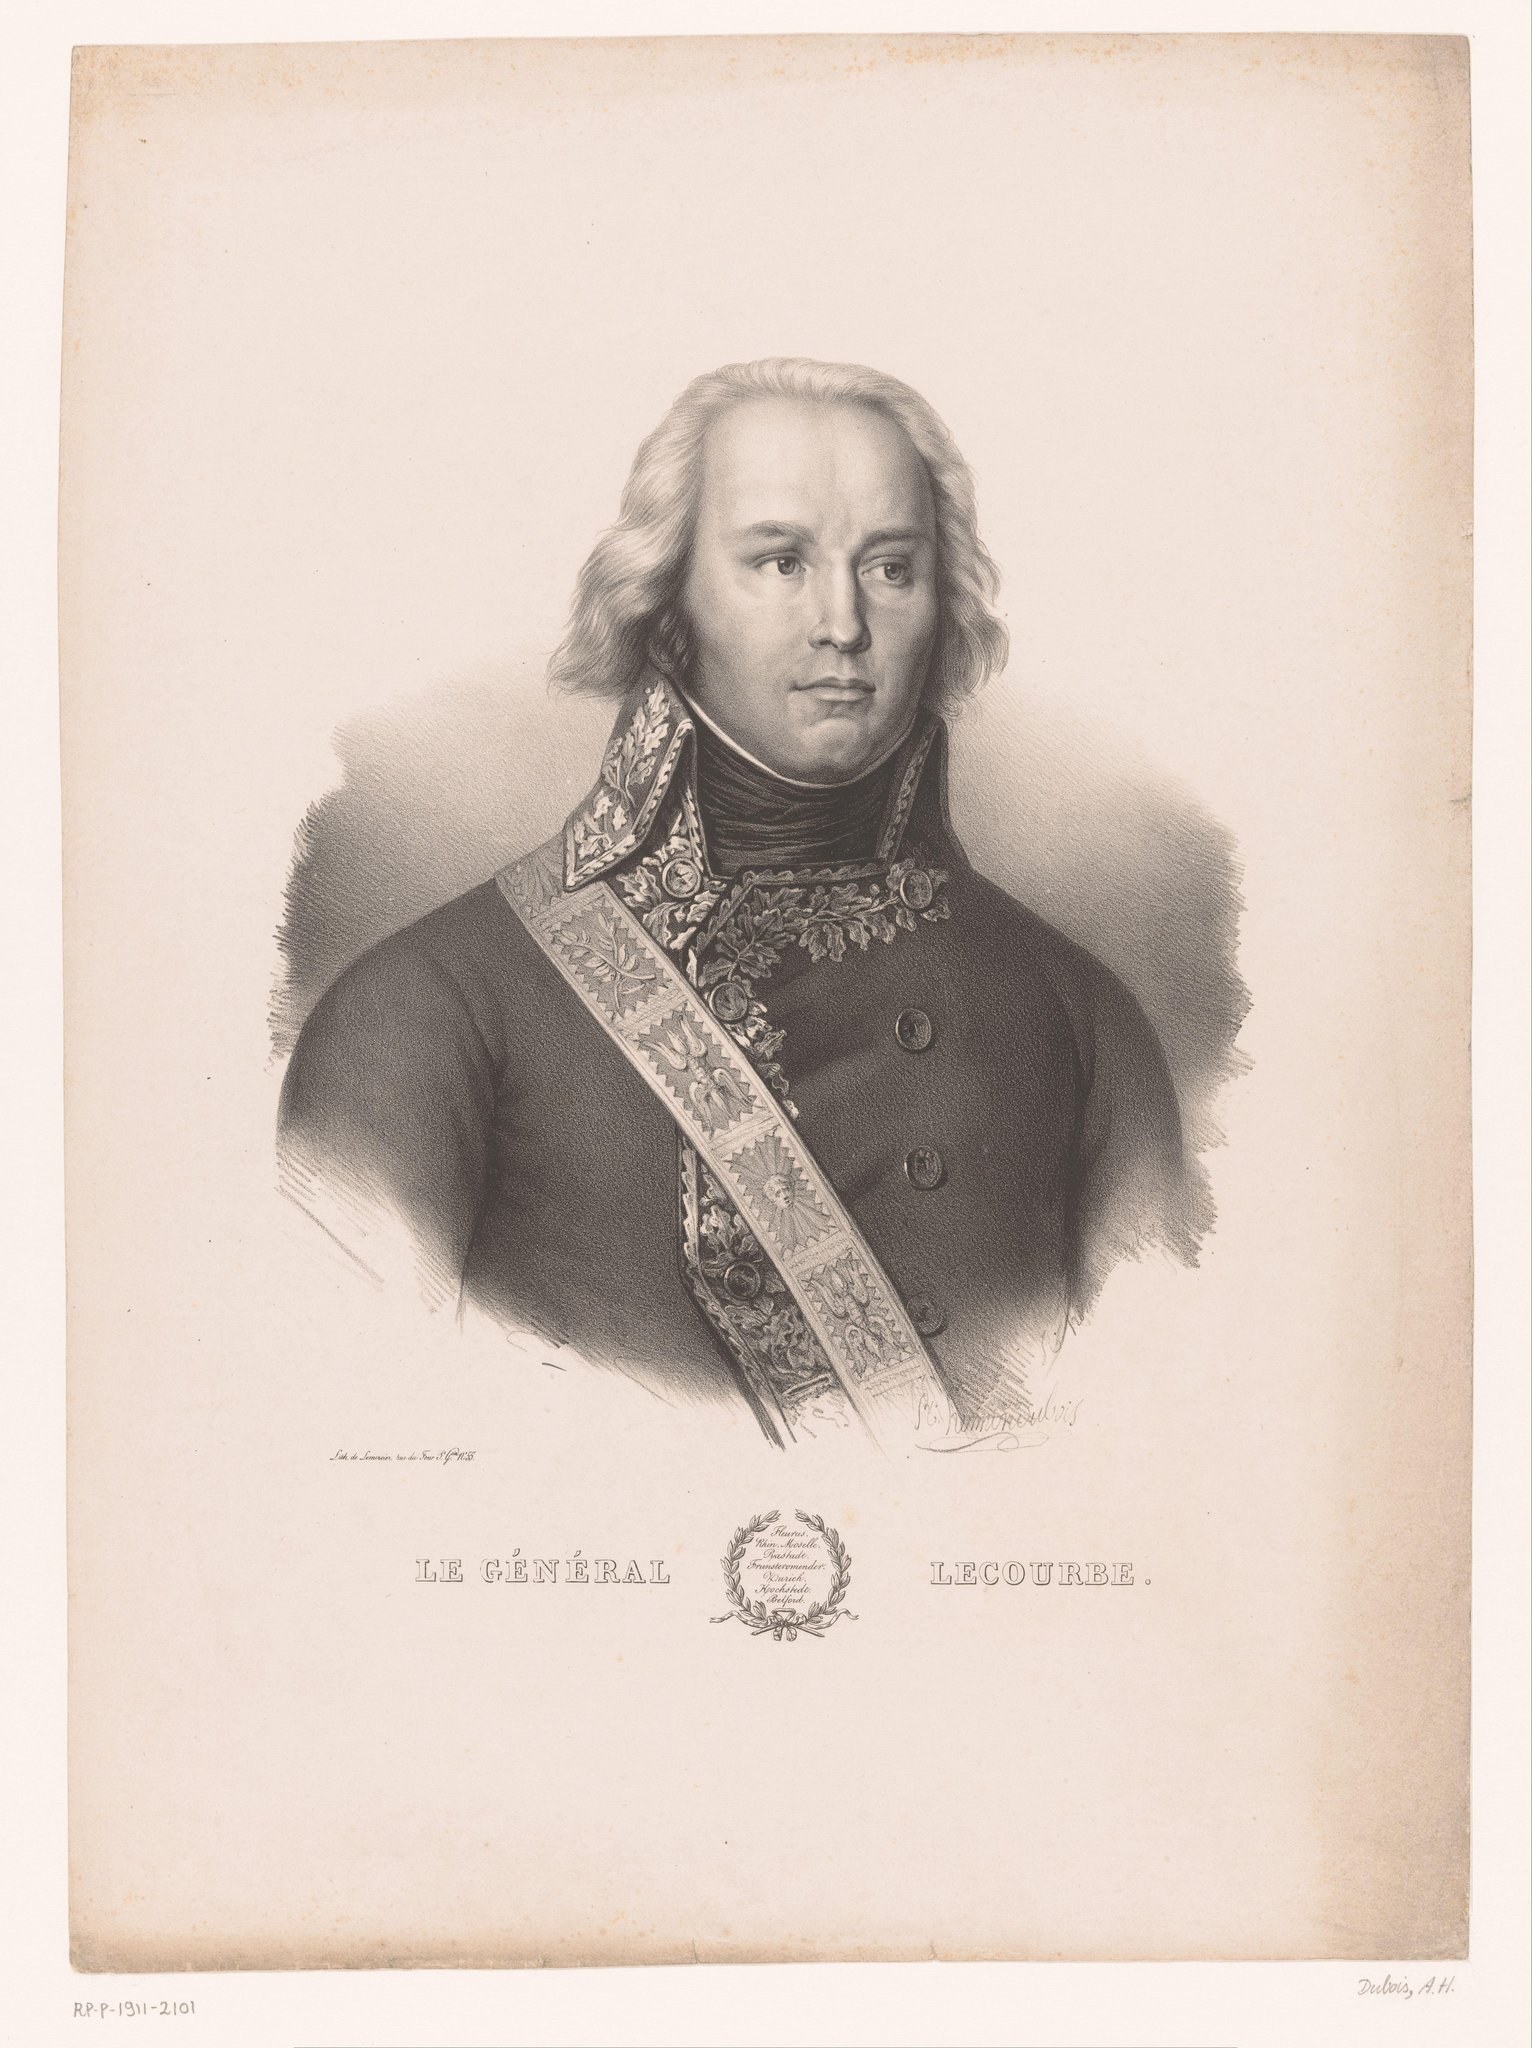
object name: print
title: Le général Lecourbe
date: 1828-1887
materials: paper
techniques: lithograph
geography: paris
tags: historical persons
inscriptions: collector's mark: Lugt 2228a